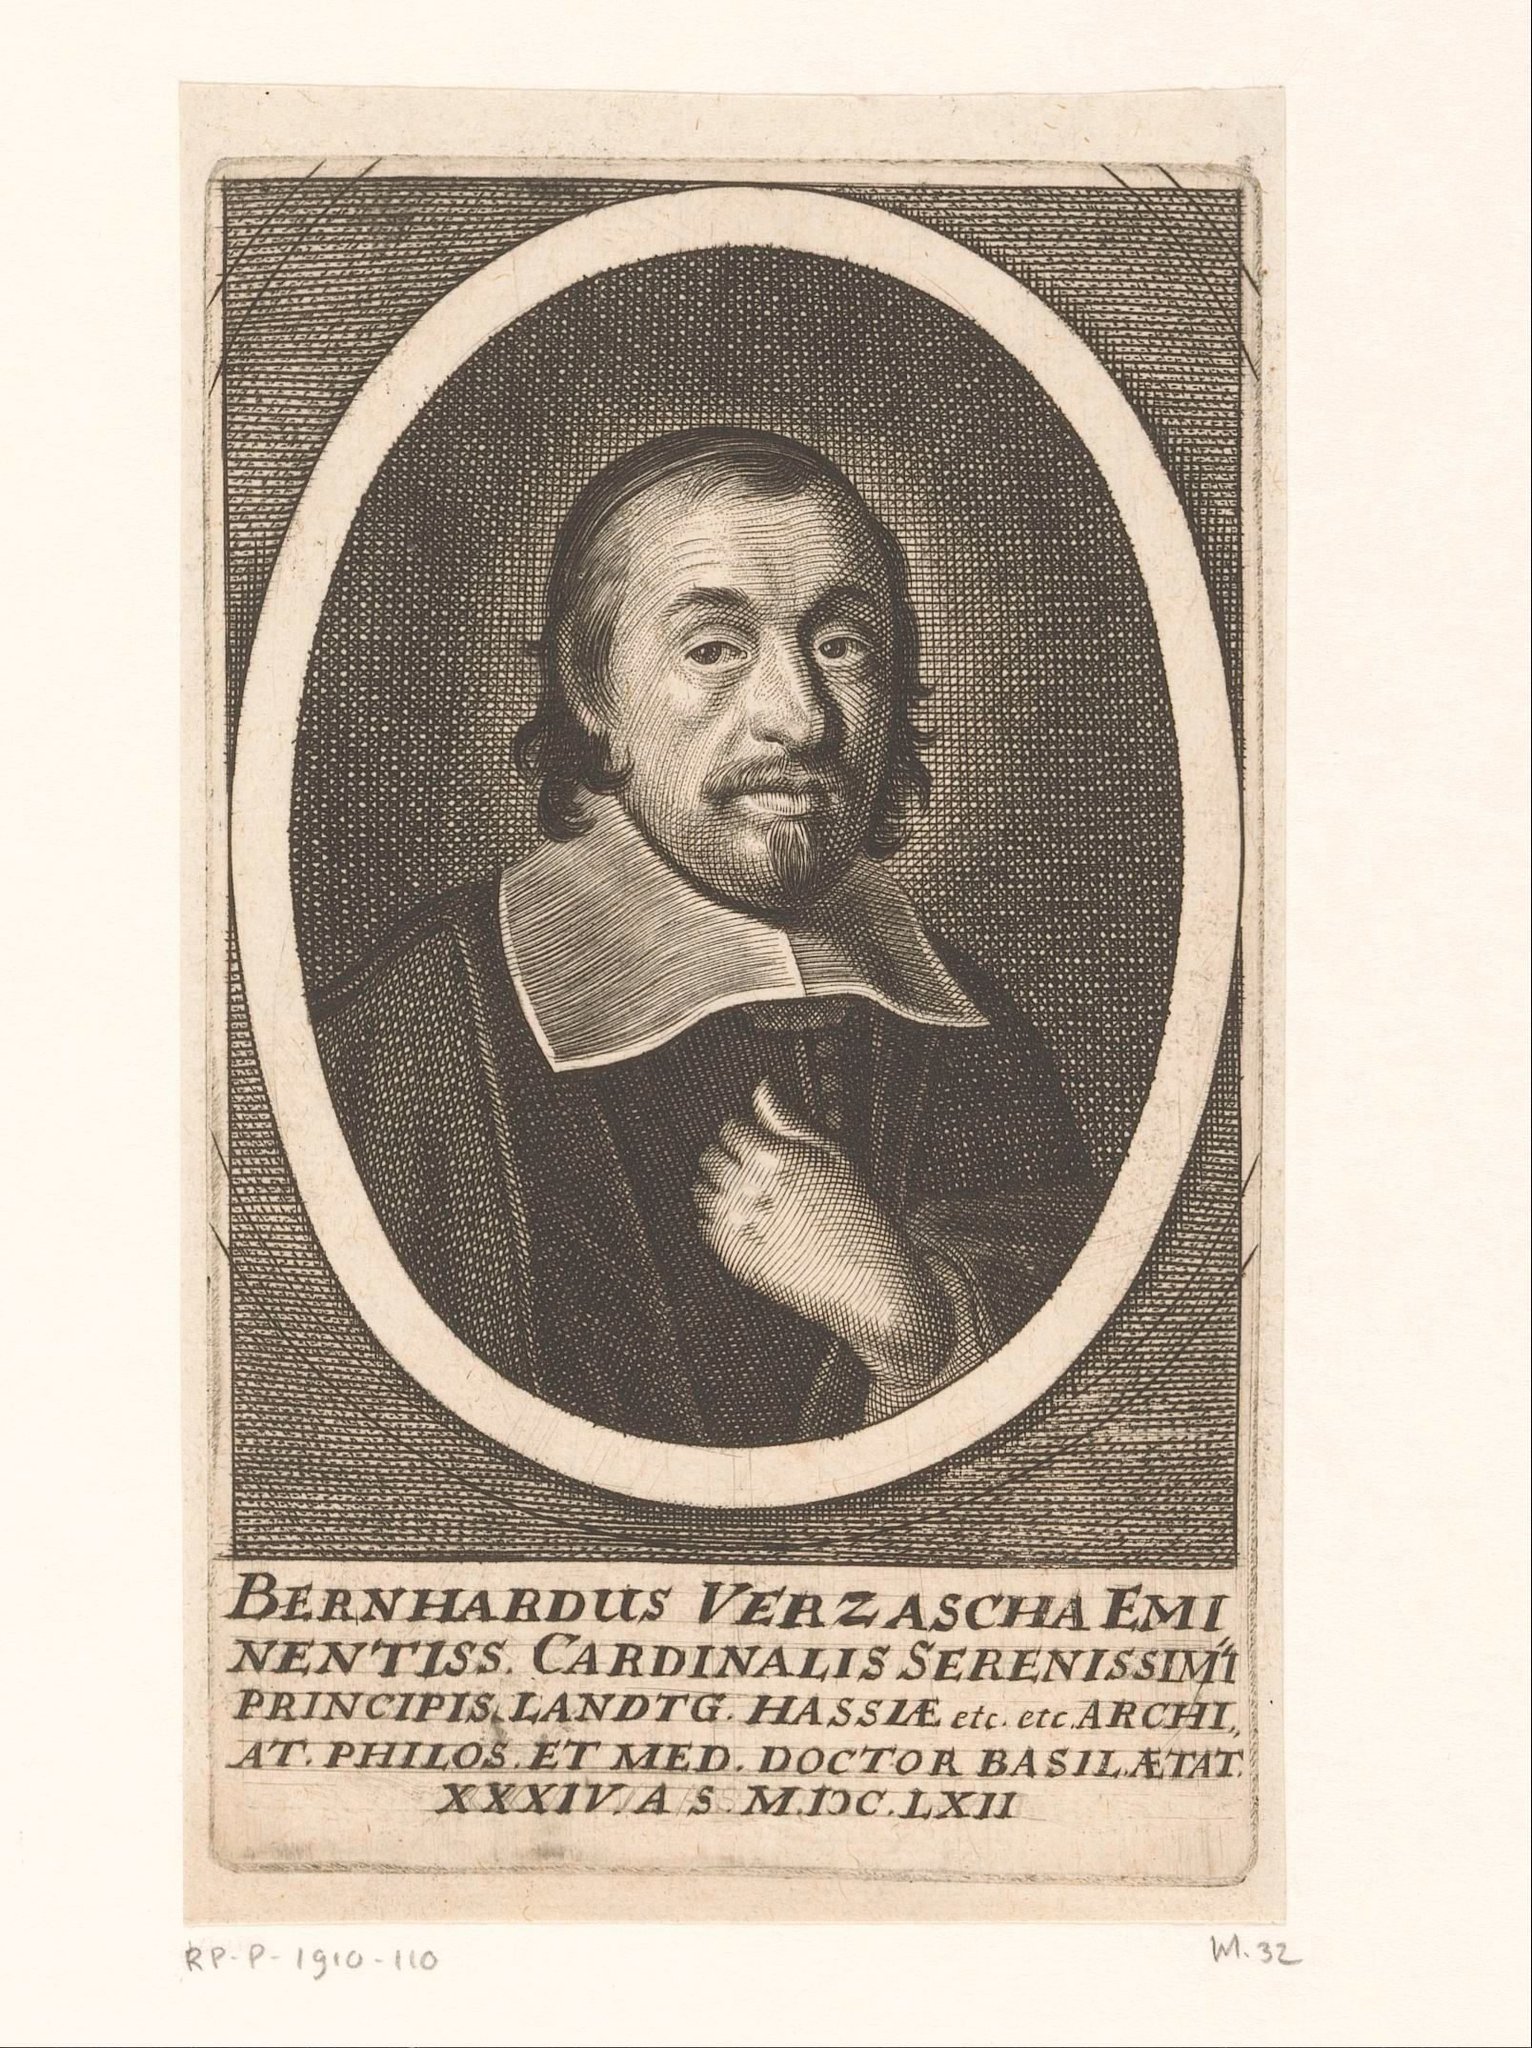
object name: print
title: Bernhardus Verzascha (...)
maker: peter aubry (iii)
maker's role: print maker, publisher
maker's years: 1610-1686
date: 1662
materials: paper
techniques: engraving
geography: straatsburg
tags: historical persons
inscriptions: collector's mark: Lugt 2228